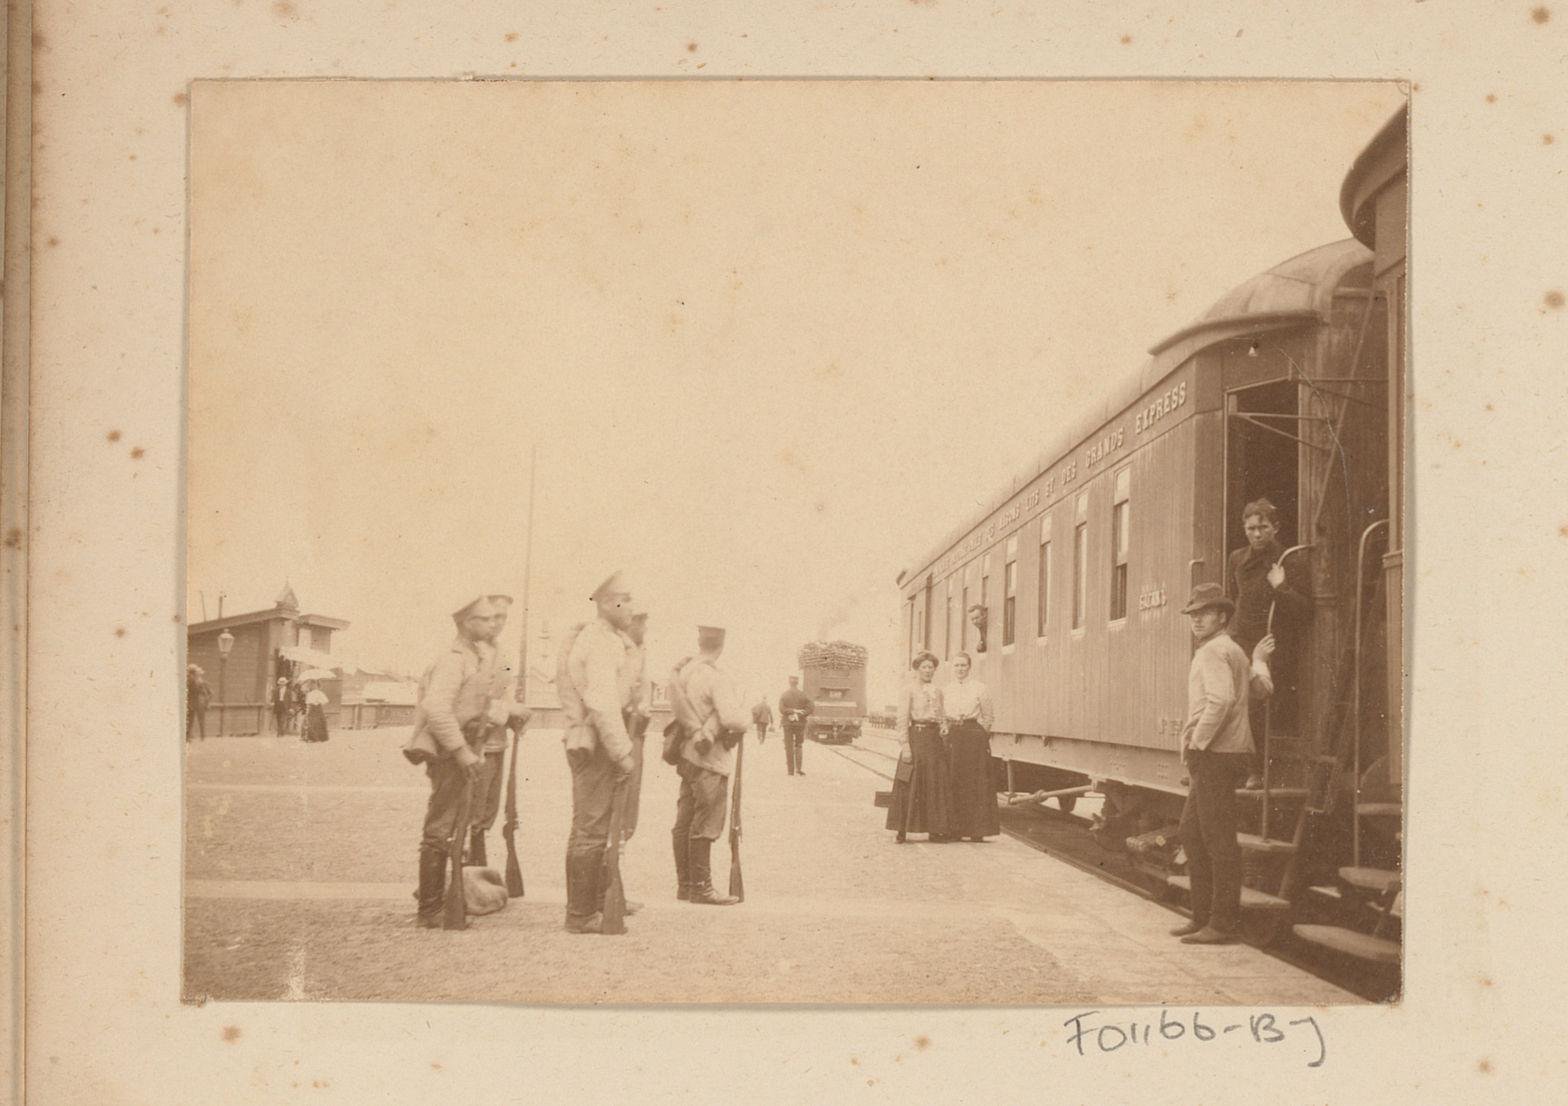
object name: album leaf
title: Soldaten en burgers op het perron bij een trein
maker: Anonymous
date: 1895-1910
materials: photographic support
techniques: daylight paper print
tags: adult woman, railway wagon, adult man, historical persons, the soldier; the soldier's life, france